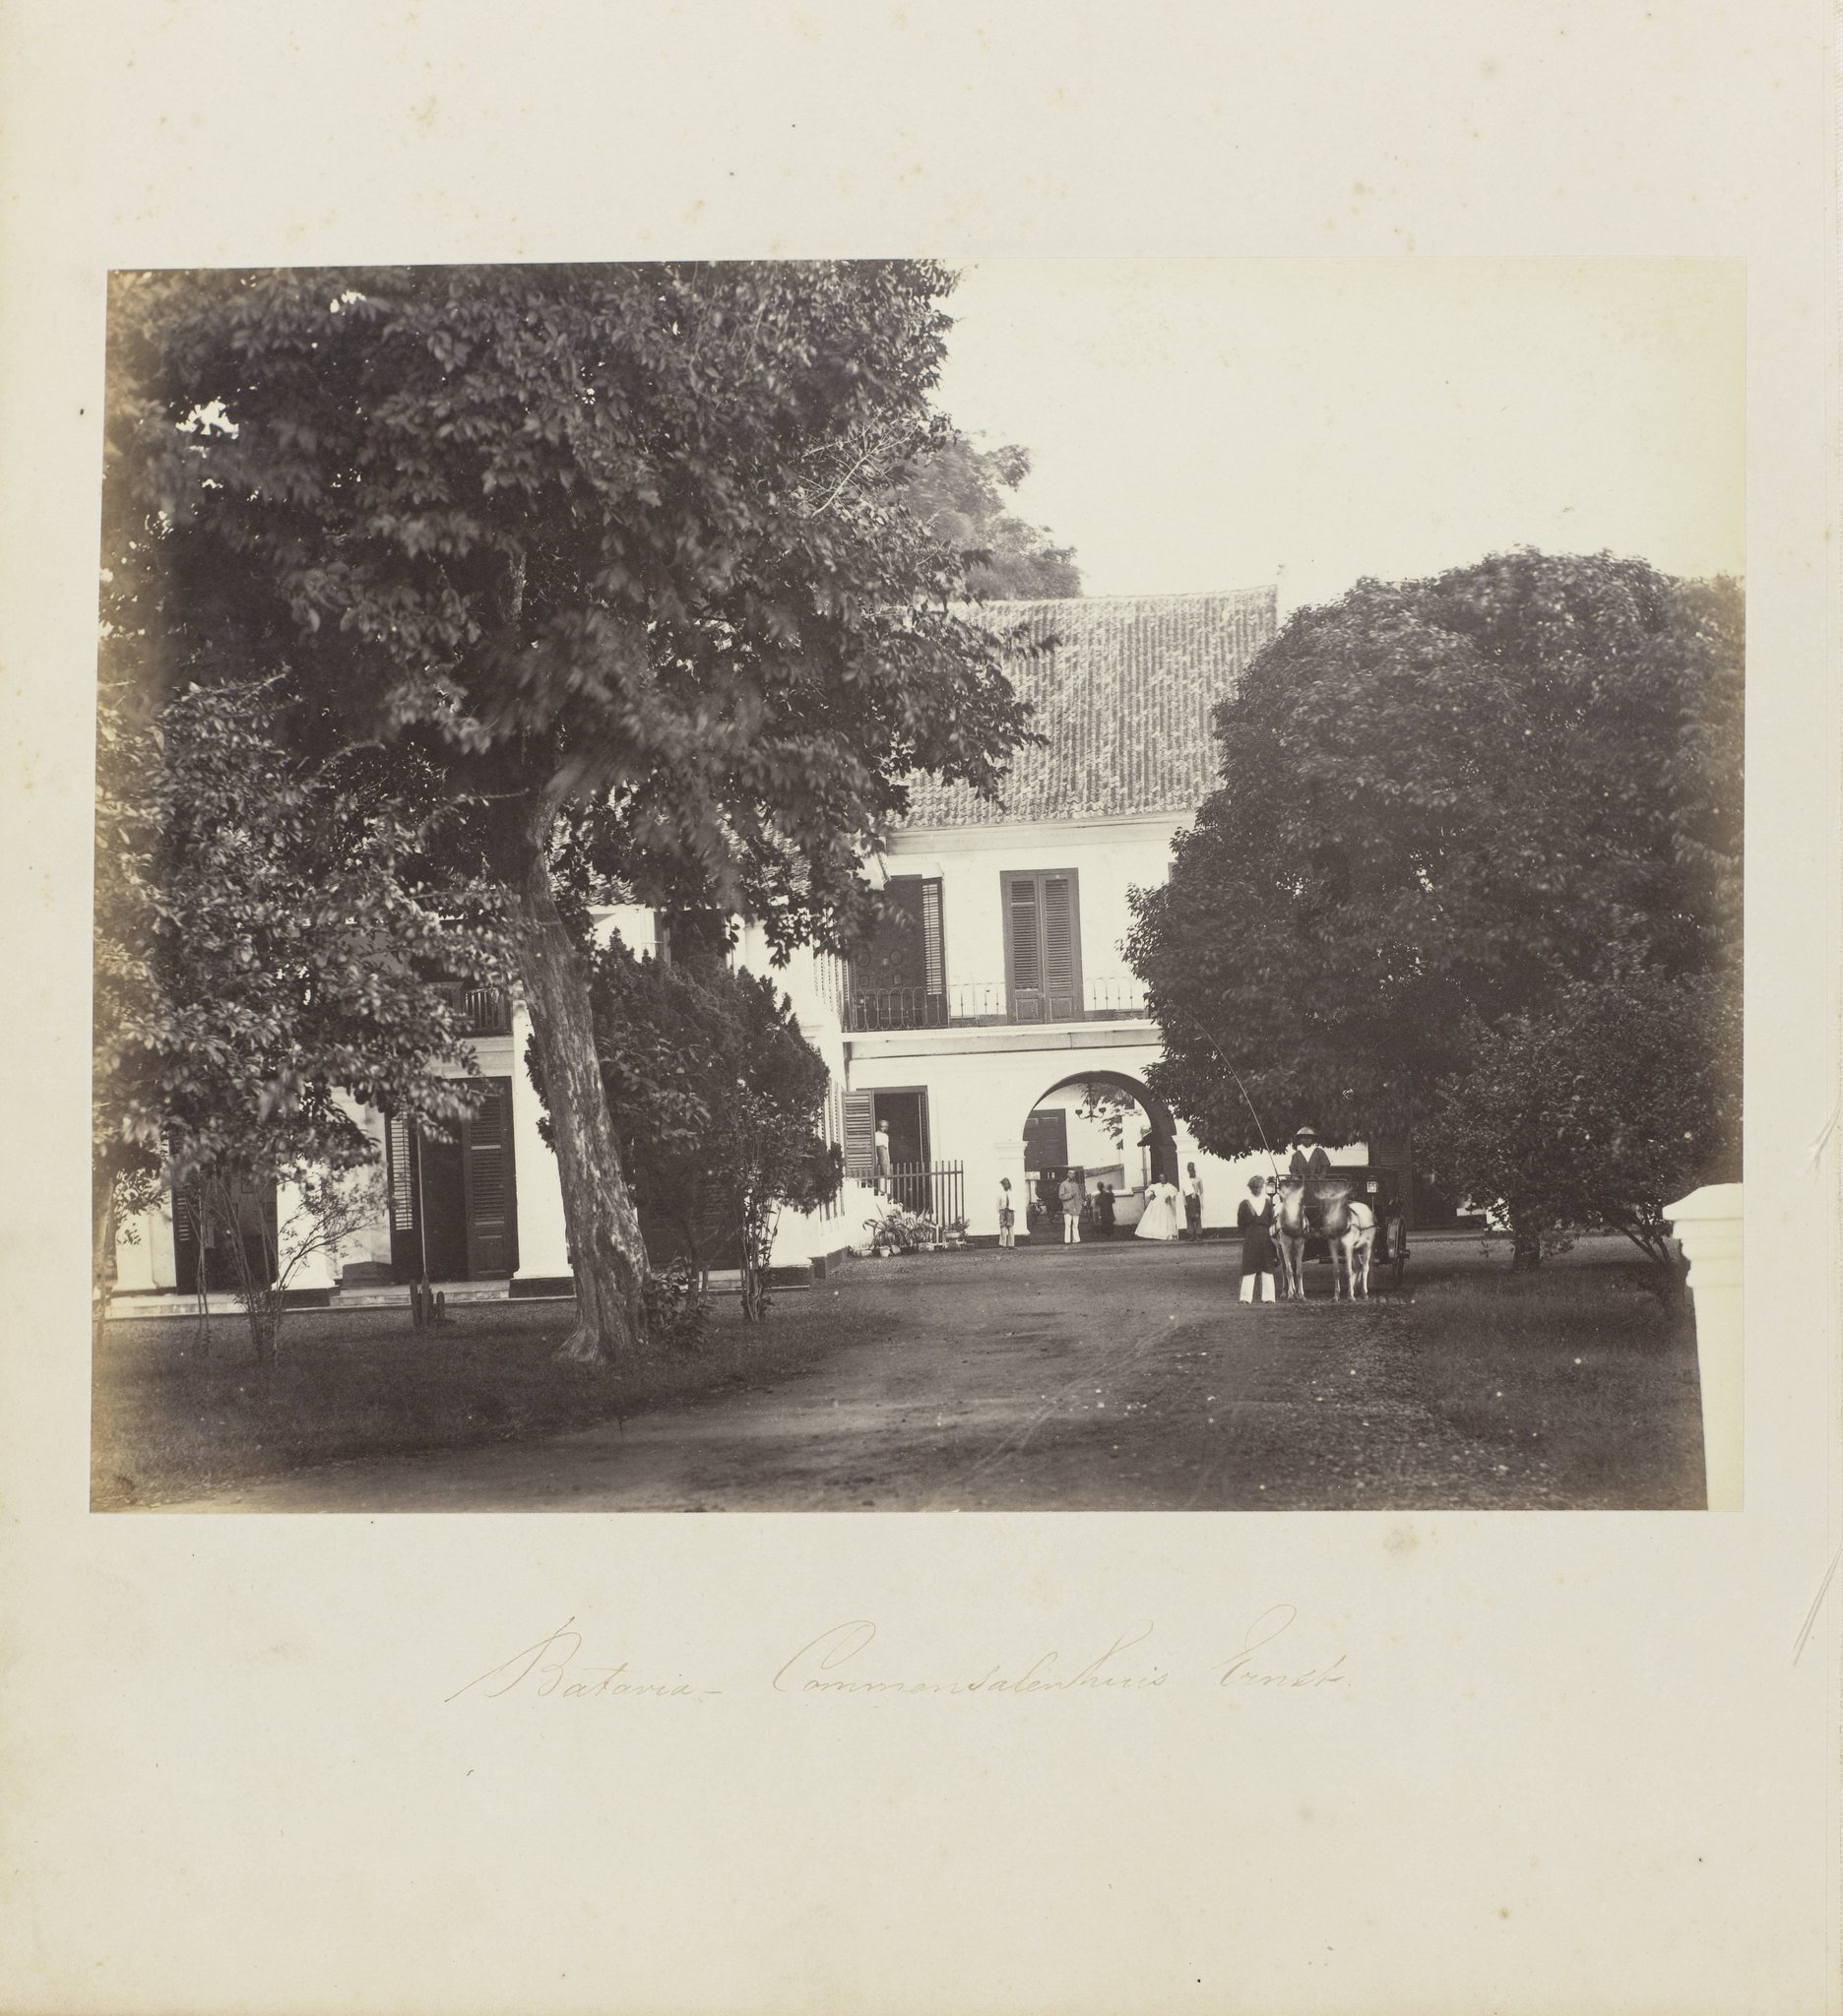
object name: photograph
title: Batavia - Commensalenhuis Ernst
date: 1863-1866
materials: photographic support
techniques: albumen print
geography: batavia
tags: hotel, hostelry, inn, batavia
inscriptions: inscription: ‘Batavia - Commensalenhuis Ernst’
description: Het Commensalenhuis (hotel of pensioen) genaamd Ernst, in Batavia. Onderdeel van het rode fotoalbum met foto's van Java, uit het bezit van apotheker Specht-Grijp, die in 1865 vanuit Batavia naar Nederland terugkeerde.